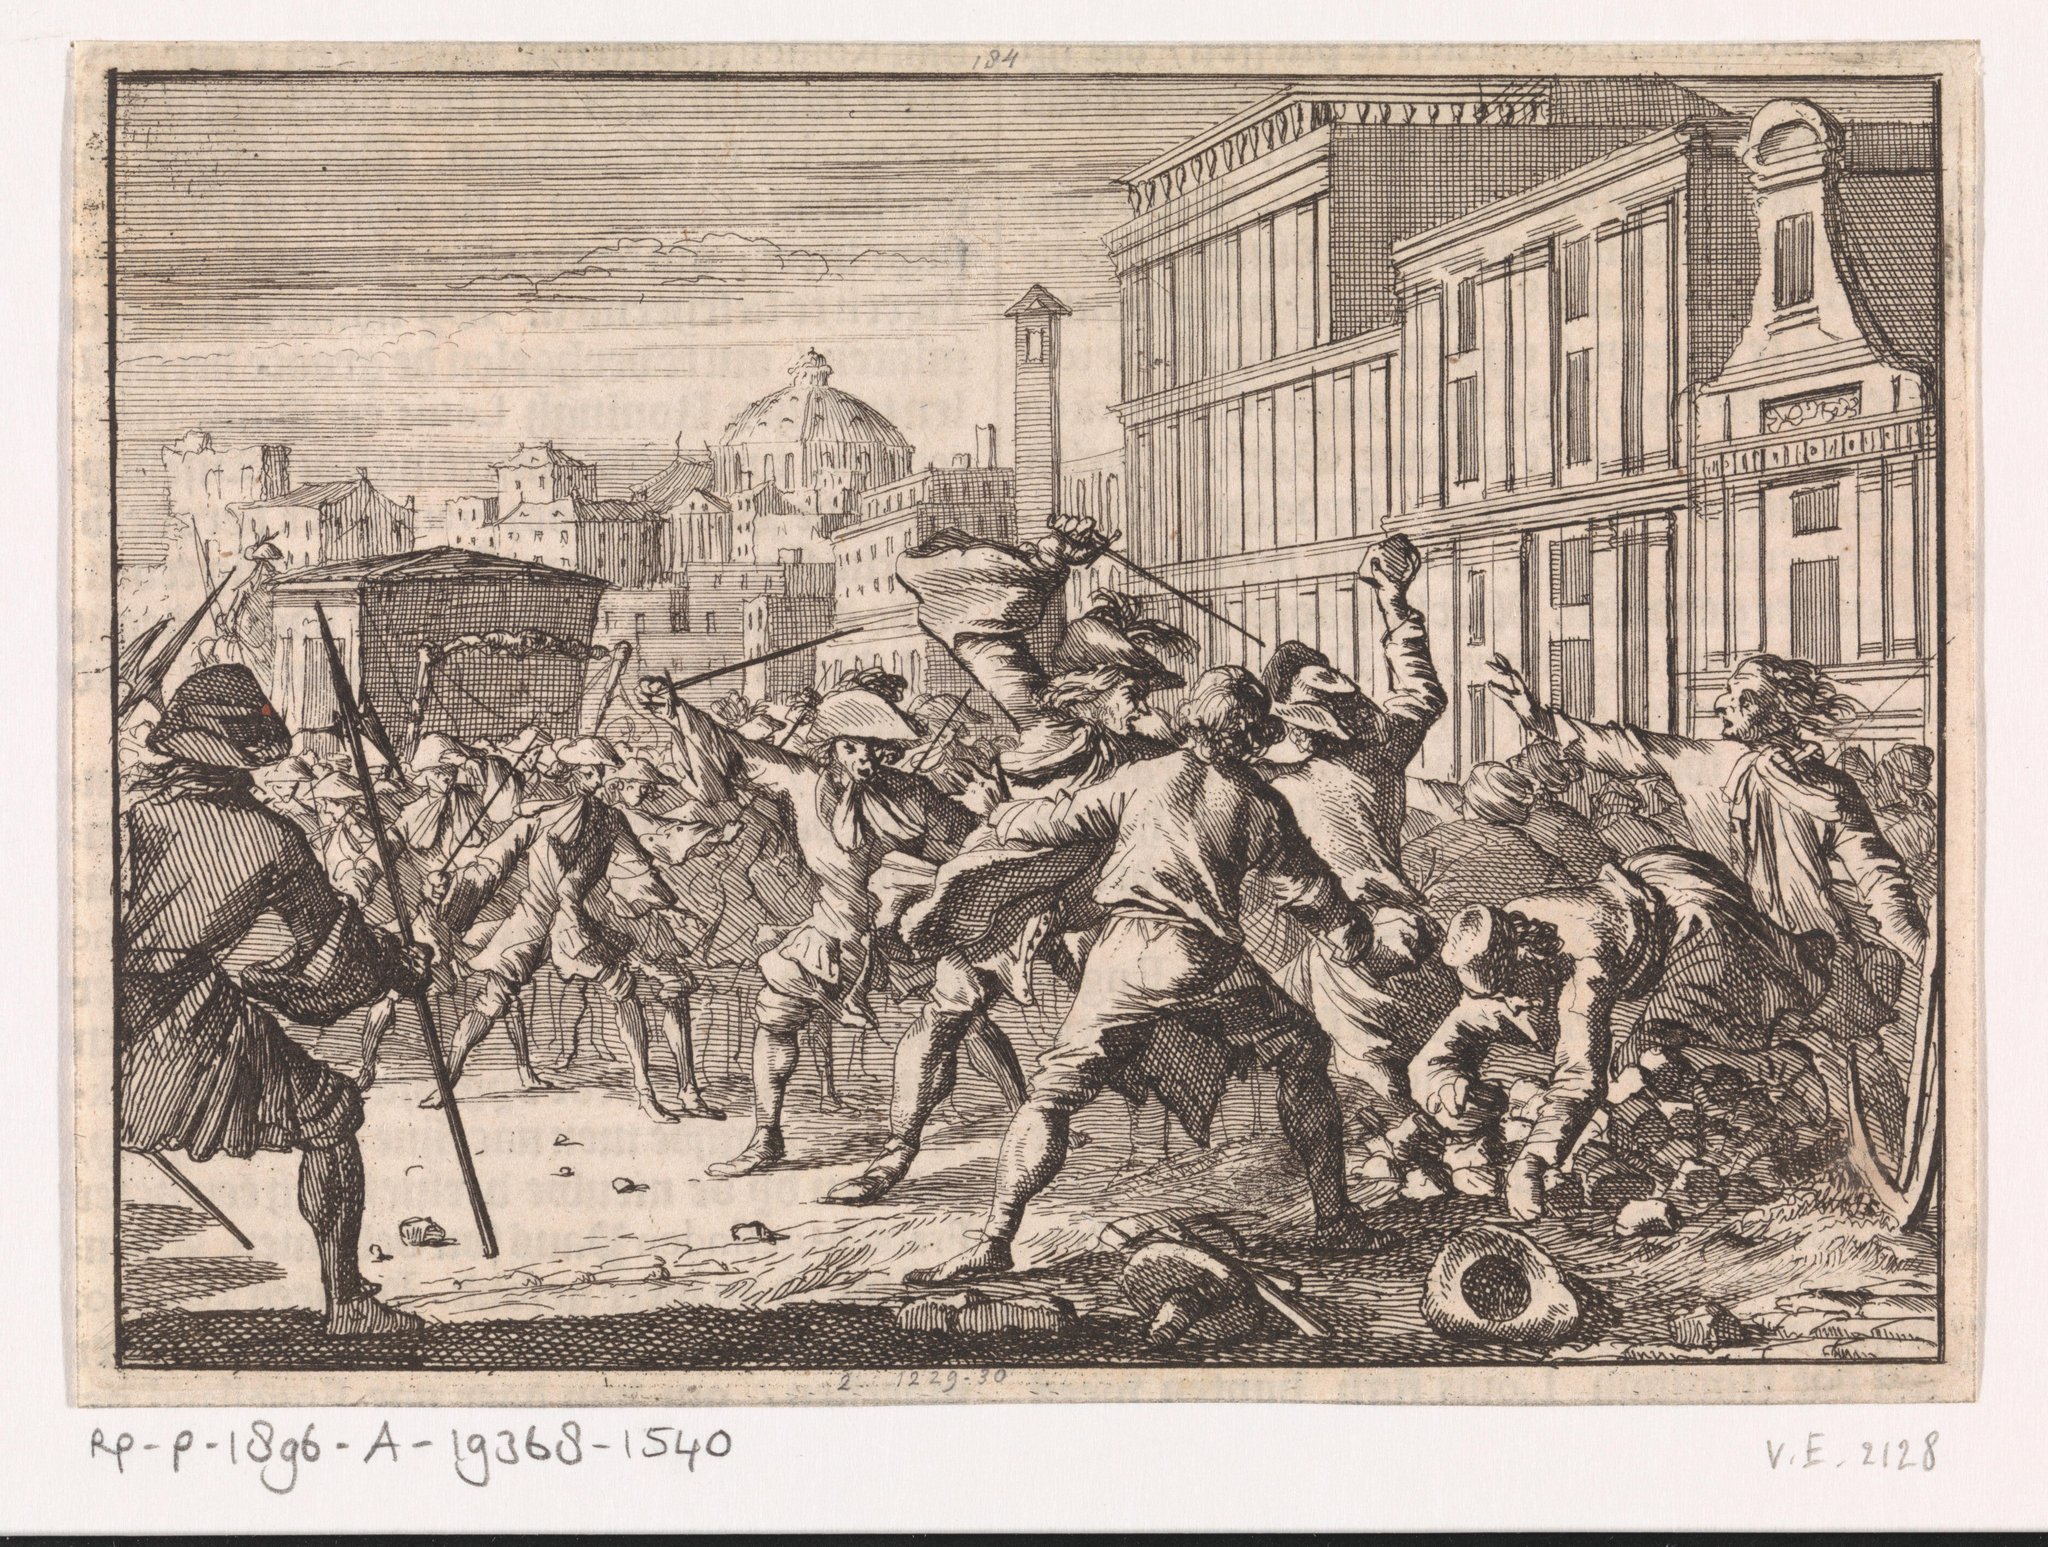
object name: book illustration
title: Gevecht te Rome tussen de dienaren van de Franse ambassadeur en enige straatmakers, 1679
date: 1698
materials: paper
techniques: etching, letterpress printing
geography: amsterdam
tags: fighting, rome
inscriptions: collector's mark: Lugt 2228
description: Illustratie uit: Gottfried, Johann Ludwig. Historische kronyck; vervattende een (...) beschrijvingh der aldergedenckwaerdigste geschiedenissen des weerelds, van den aenvangh der scheppingh tot (...) 1576 (2 delen). Leiden: Pieter van der Aa, 1698, dl. II, p. 1229.